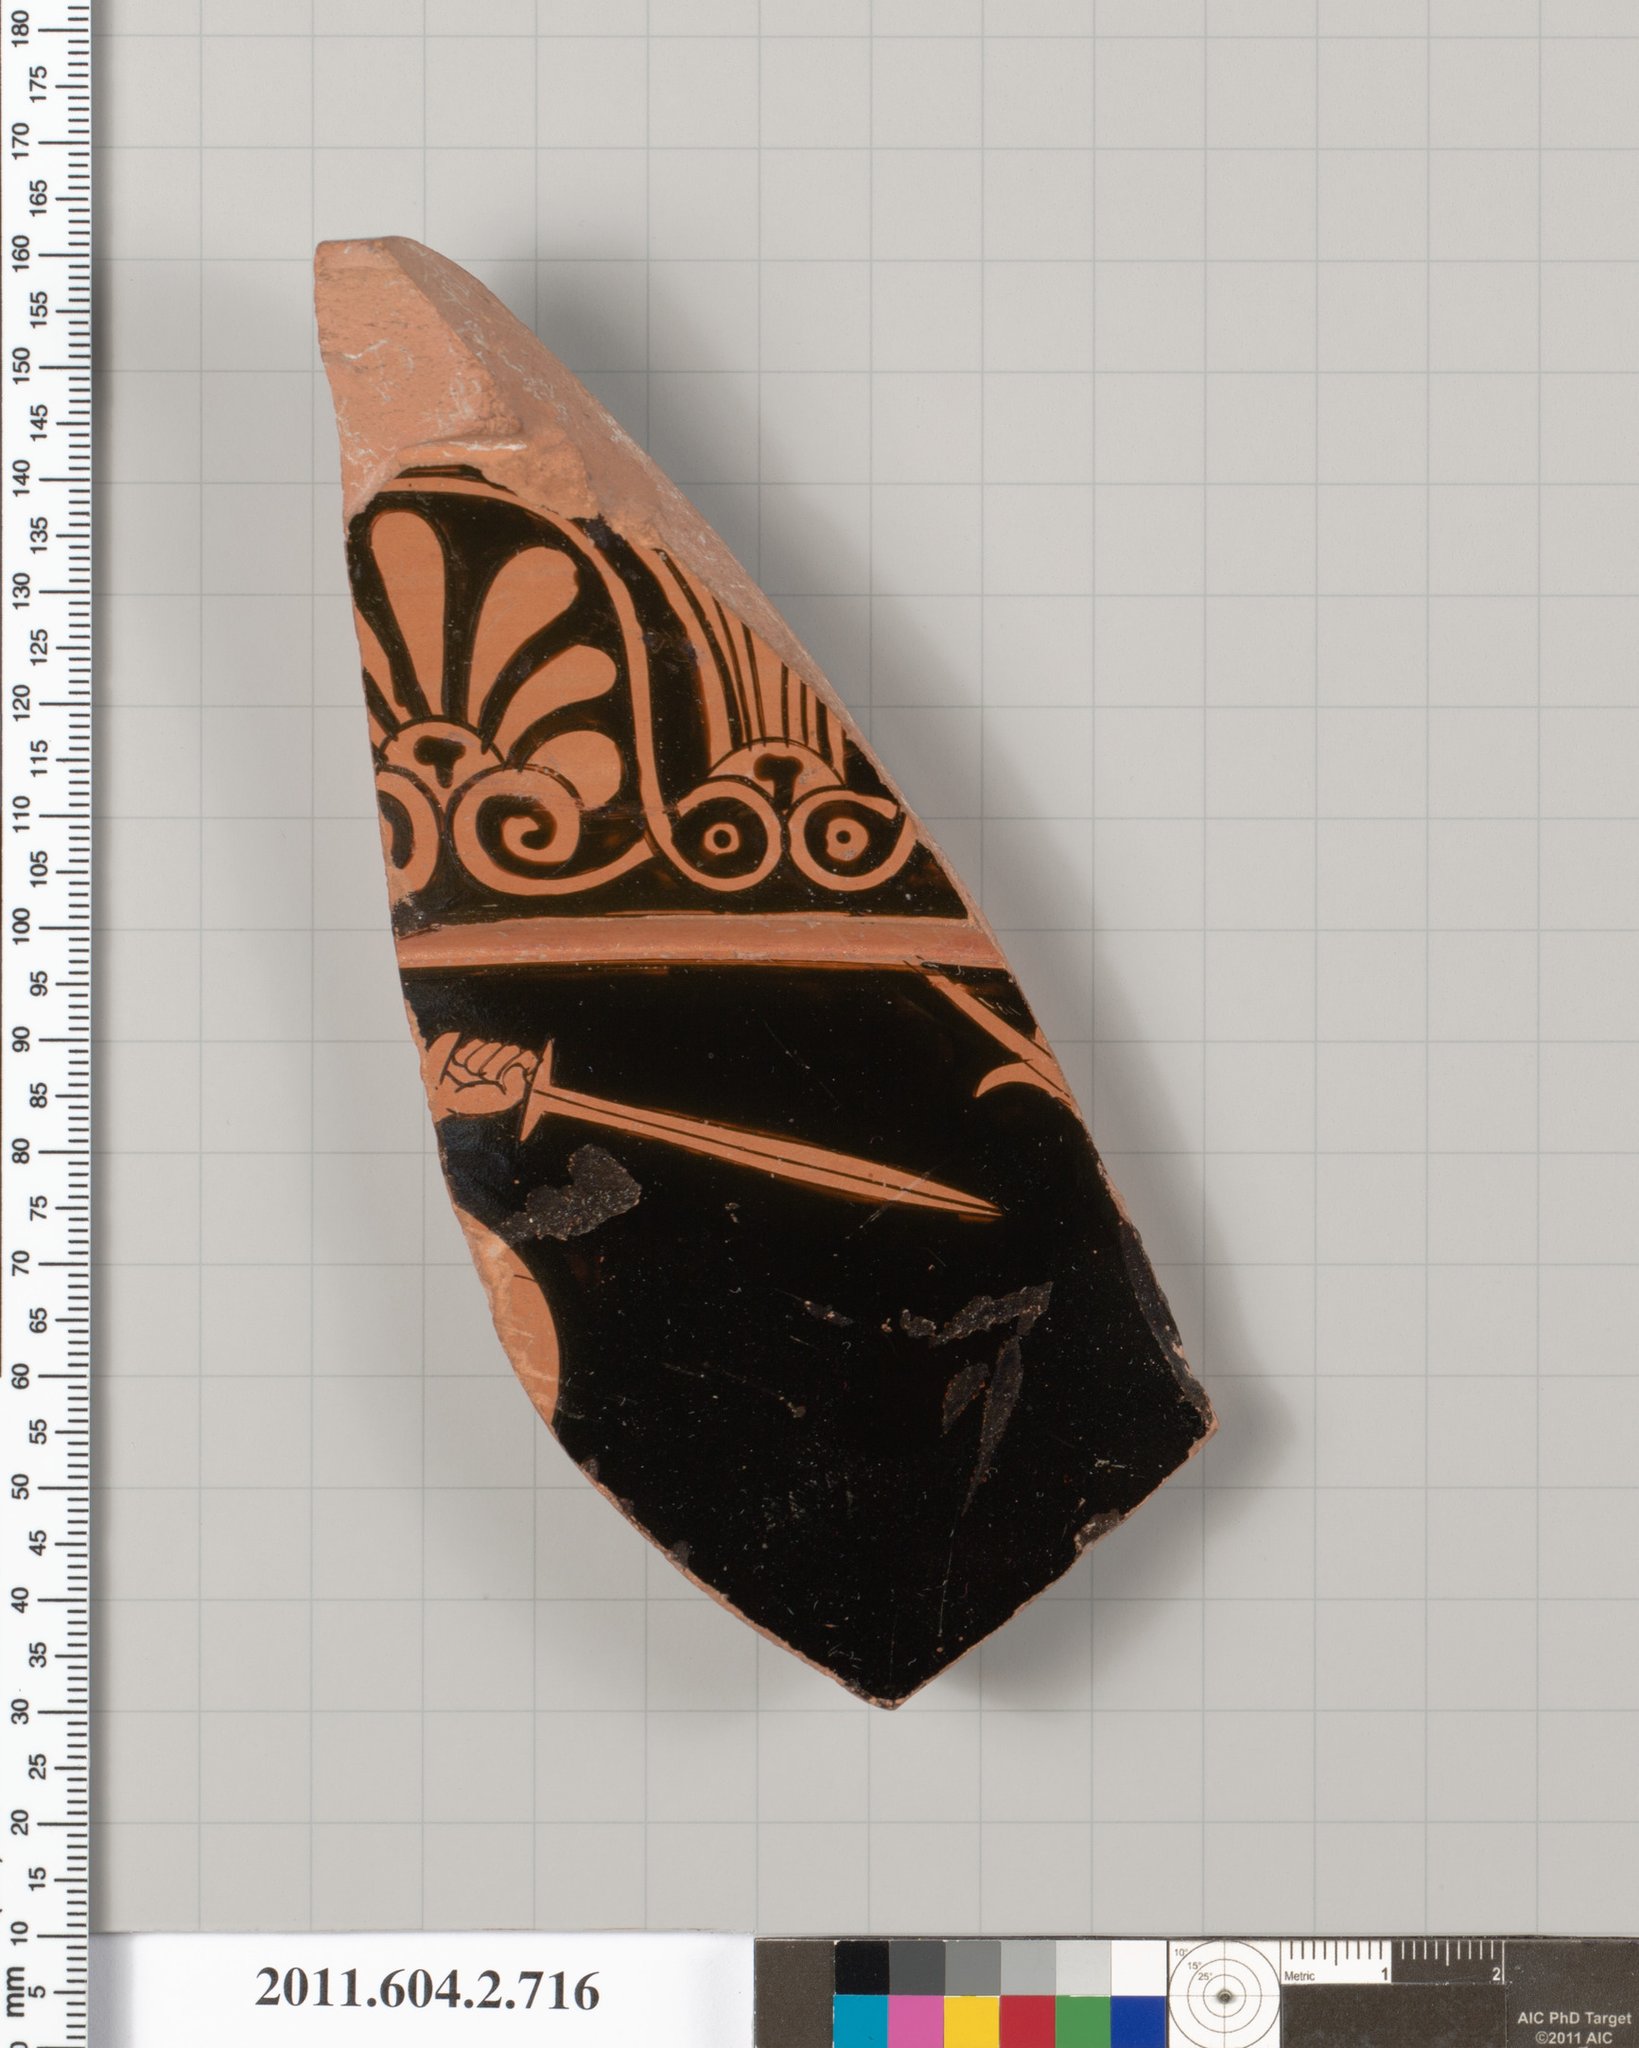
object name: calyx krater fragment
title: Terracotta fragment of a calyx-krater (bowl for mixing wine and water)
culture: greek, attic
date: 500-476 BCE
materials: terracotta